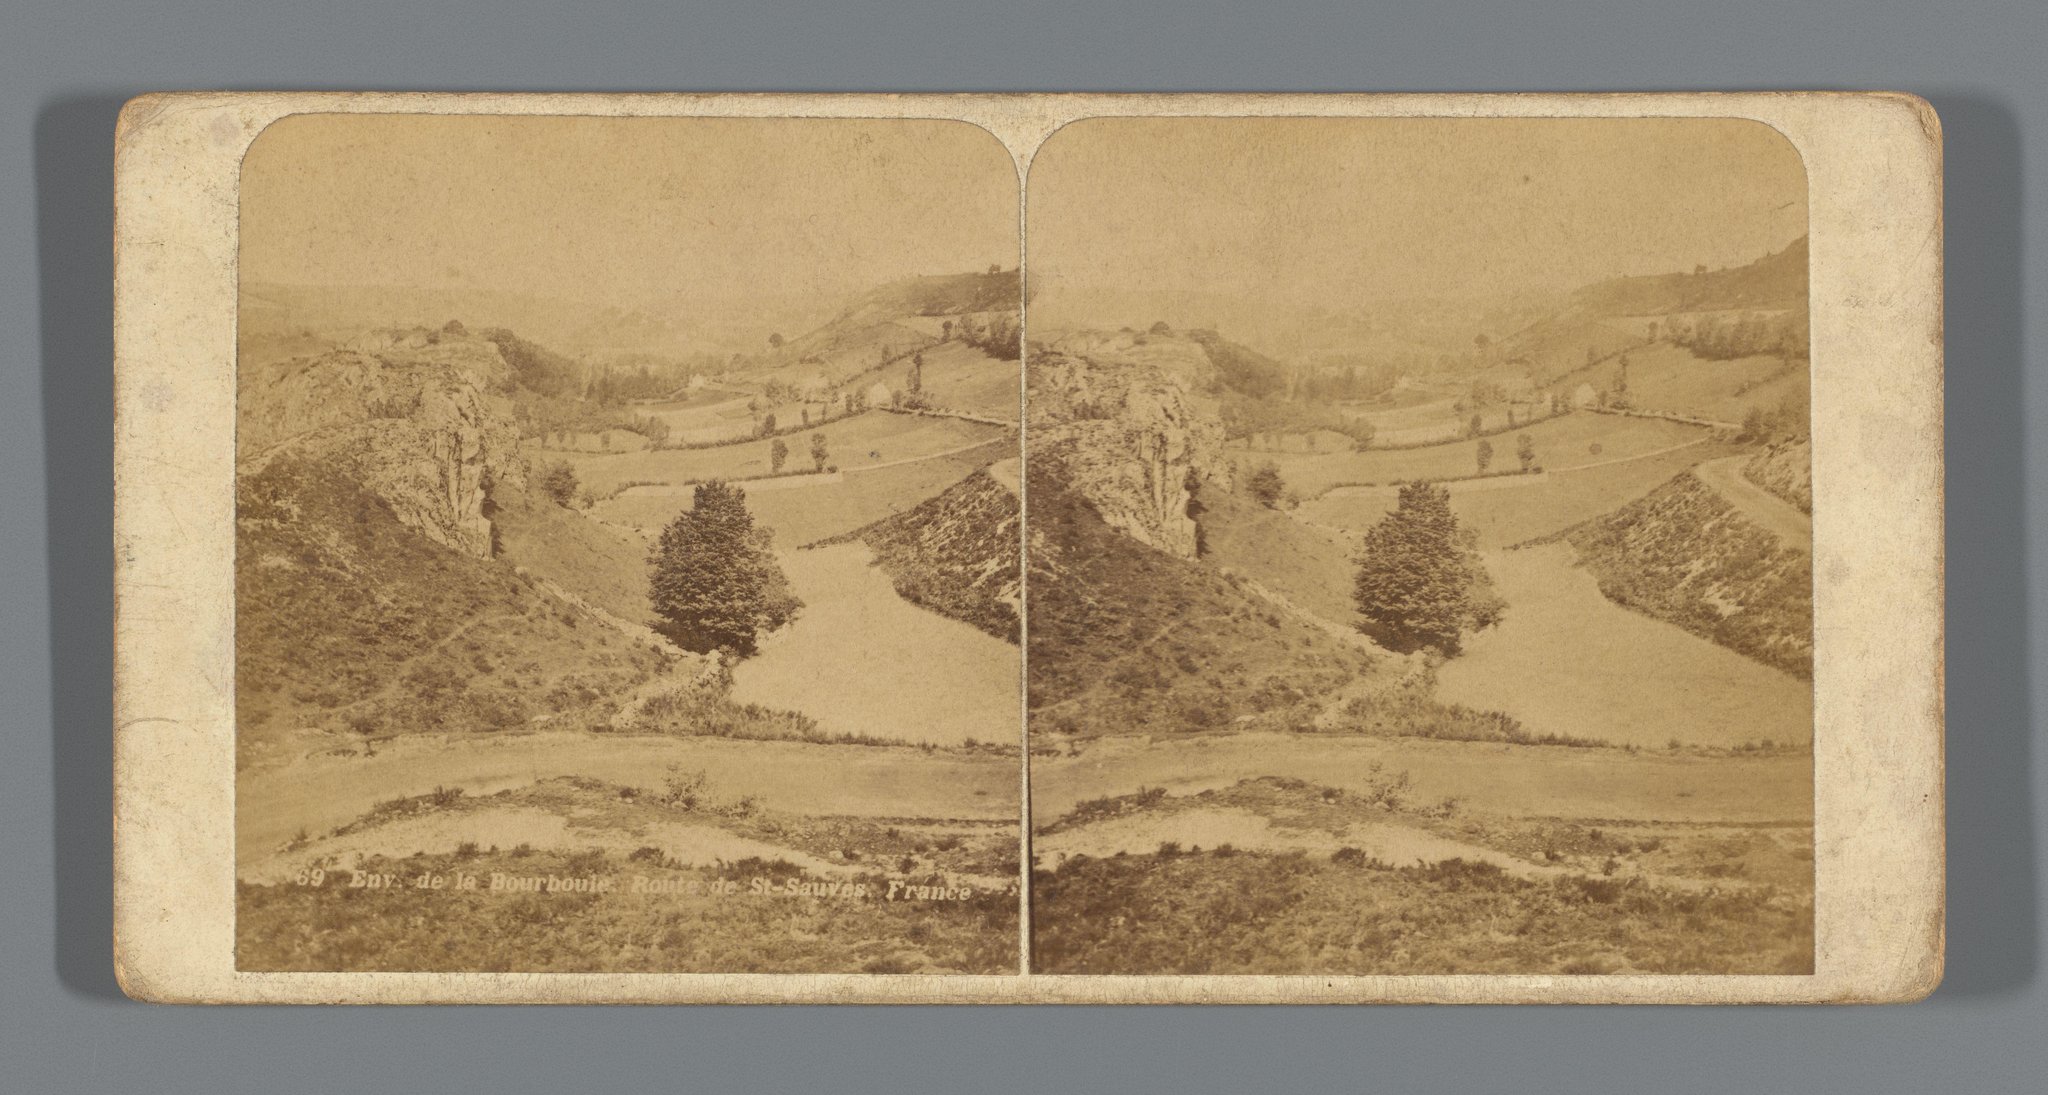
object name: stereograph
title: Aardrijkskundige Beeldengalerij, verzameld door M.J. Broekhuijsen, Hoofd eener school te Amsterdam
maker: martien johan broekhuijsen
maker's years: 1871-1956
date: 1905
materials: photographic support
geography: amsterdam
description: Onderdeel van een groep van 52 stereofoto's gebruikt in het lager onderwijs als aanvulling op schoolplaten. De gehele reeks bestond uit 274 nummers in 10 categorieën (A t/m K).